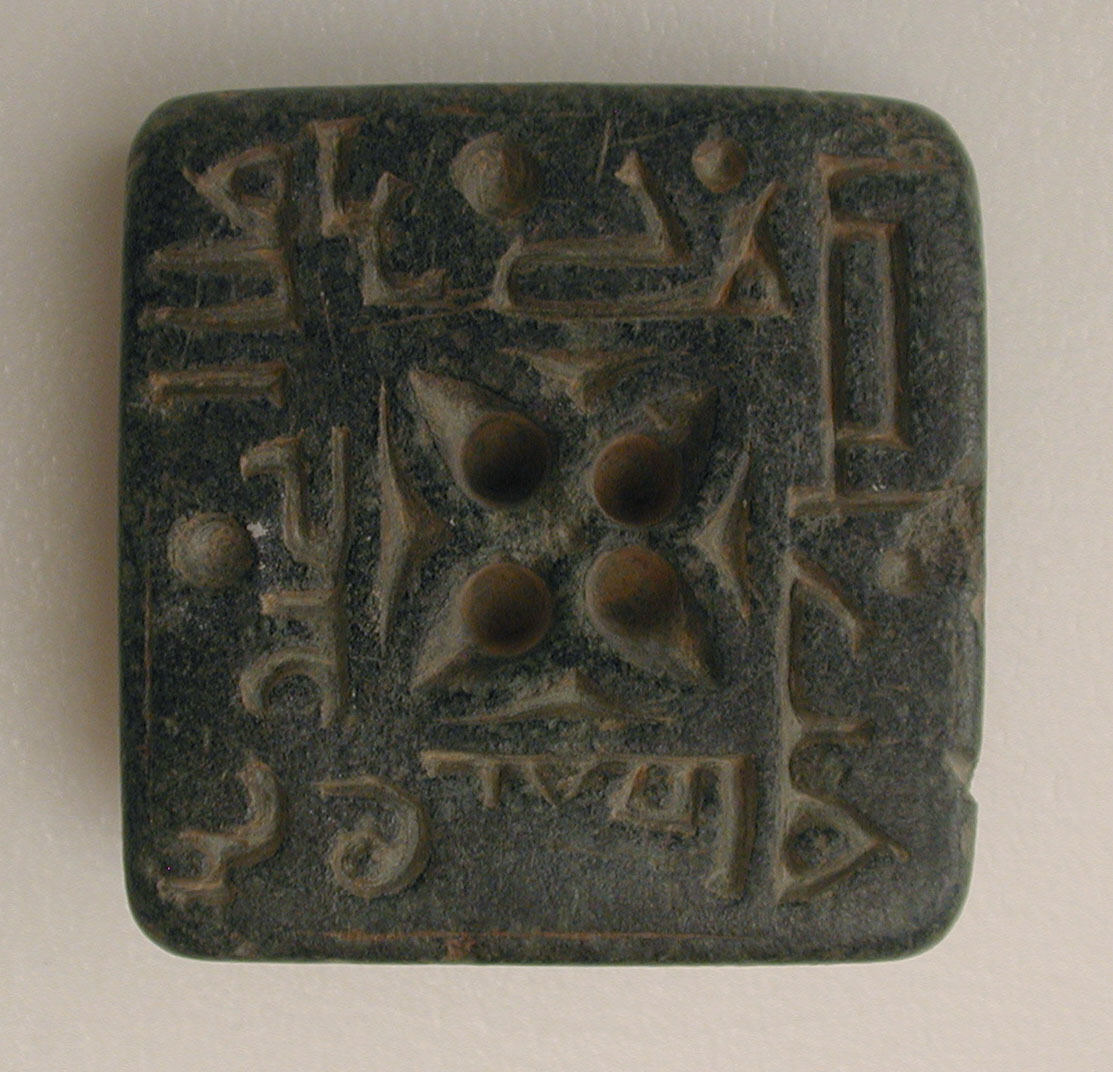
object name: seal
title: Seal inscribed "There is no God but [?]; Blessings on the owner 'Amir ibn Abdallah"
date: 901-1000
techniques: carving, incising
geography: iran